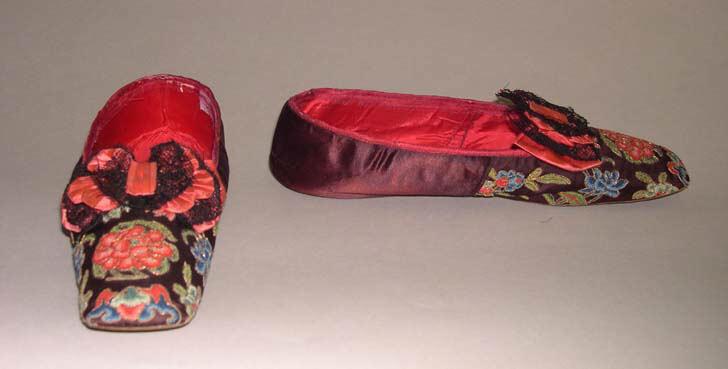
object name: shoe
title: Shoes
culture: european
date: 1834-1866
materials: cotton, leather, wool